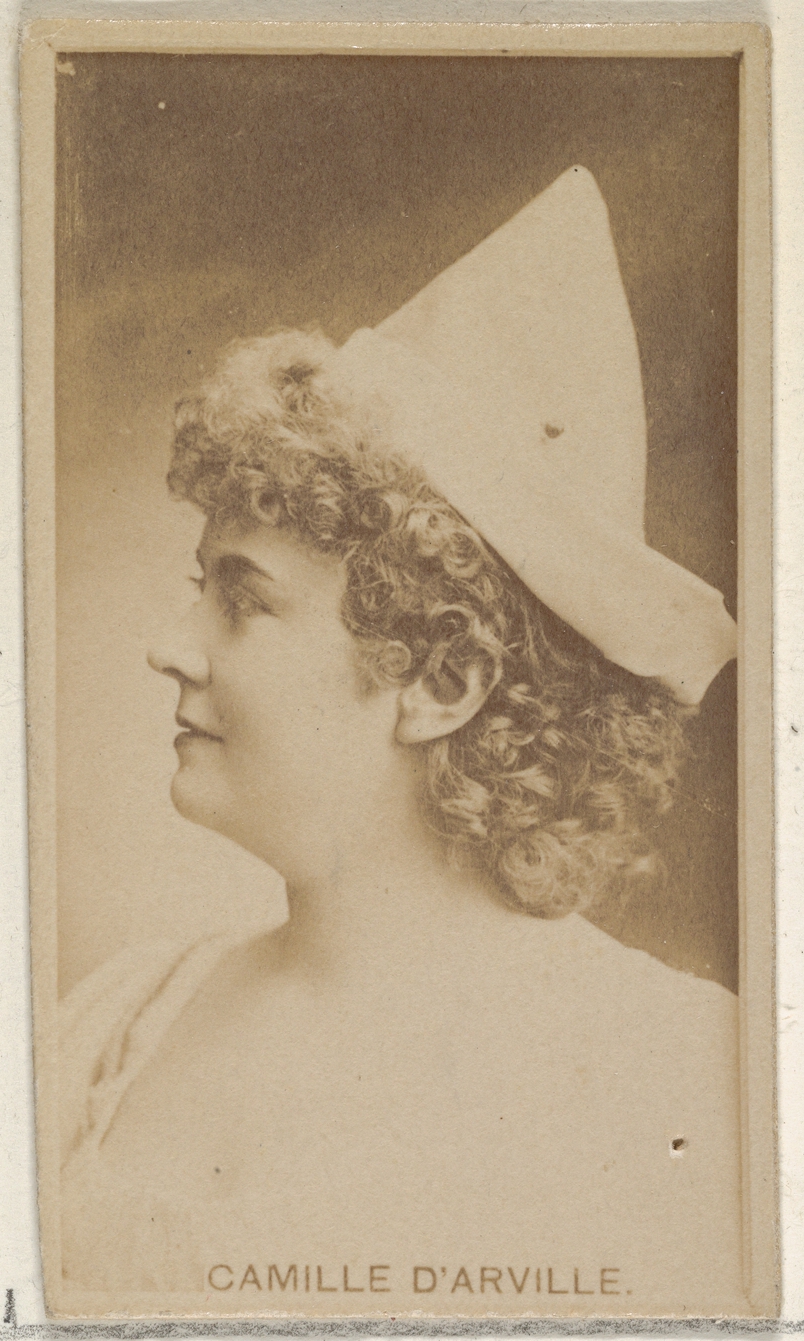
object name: photograph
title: Camille D' Arville, from the Actors and Actresses series (N45, Type 8) for Virginia Brights Cigarettes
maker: allen & ginter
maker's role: publisher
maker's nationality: american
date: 1888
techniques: albumen silver print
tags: women,actresses